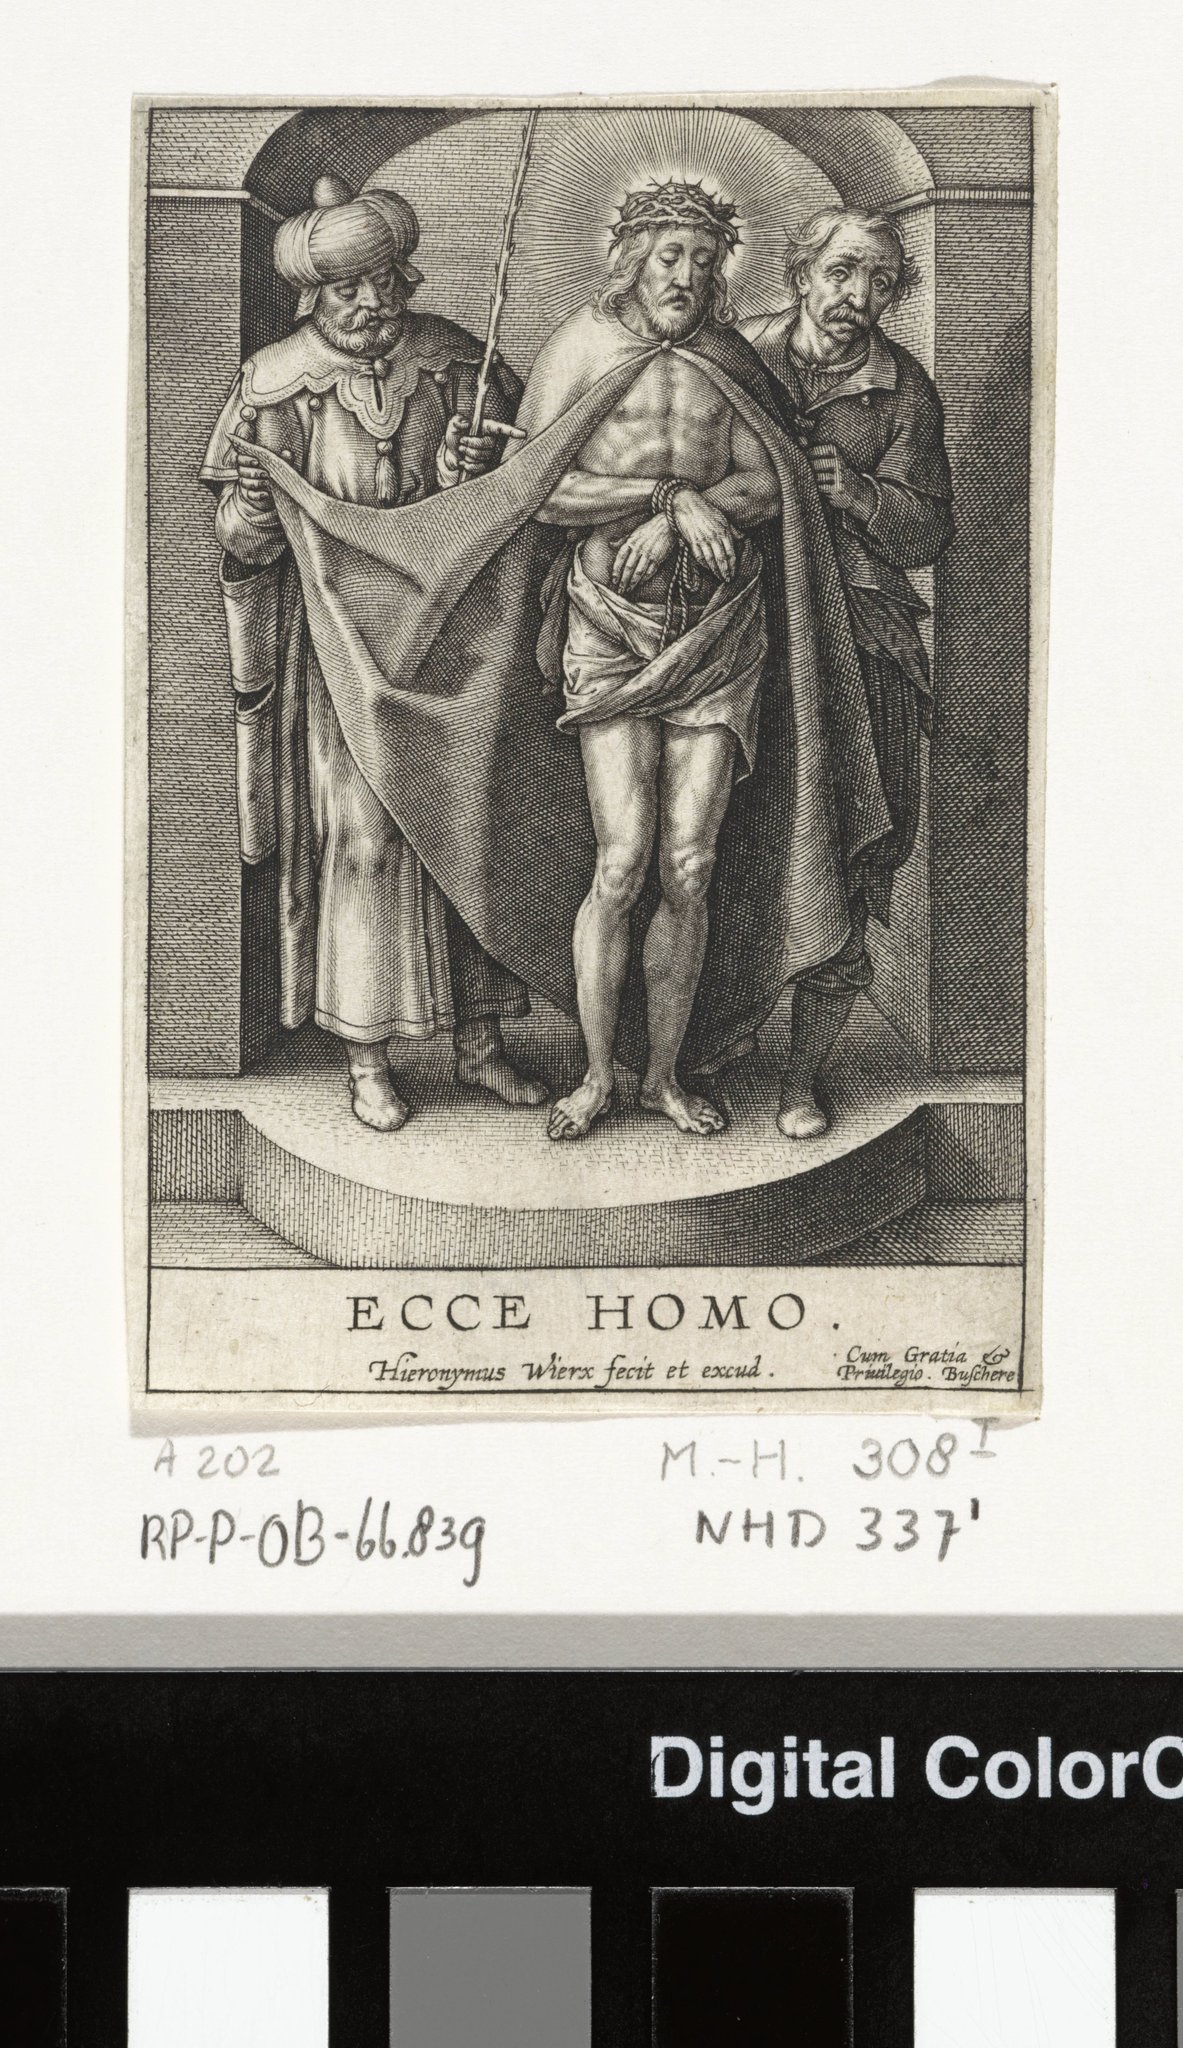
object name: print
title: Christus aan het volk getoond (Ecce Homo)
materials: paper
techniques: engraving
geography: antwerp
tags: pilate showing christ to the people, 'ostentatio christi', 'ecce homo' (john 19:4-6)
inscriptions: number: ‘37’, collector's mark: Lugt 240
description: Pontius Pilatus toont Christus, gekleed in een mantel en met doornenkroon op zijn hoofd, op een verhoging aan het volk.